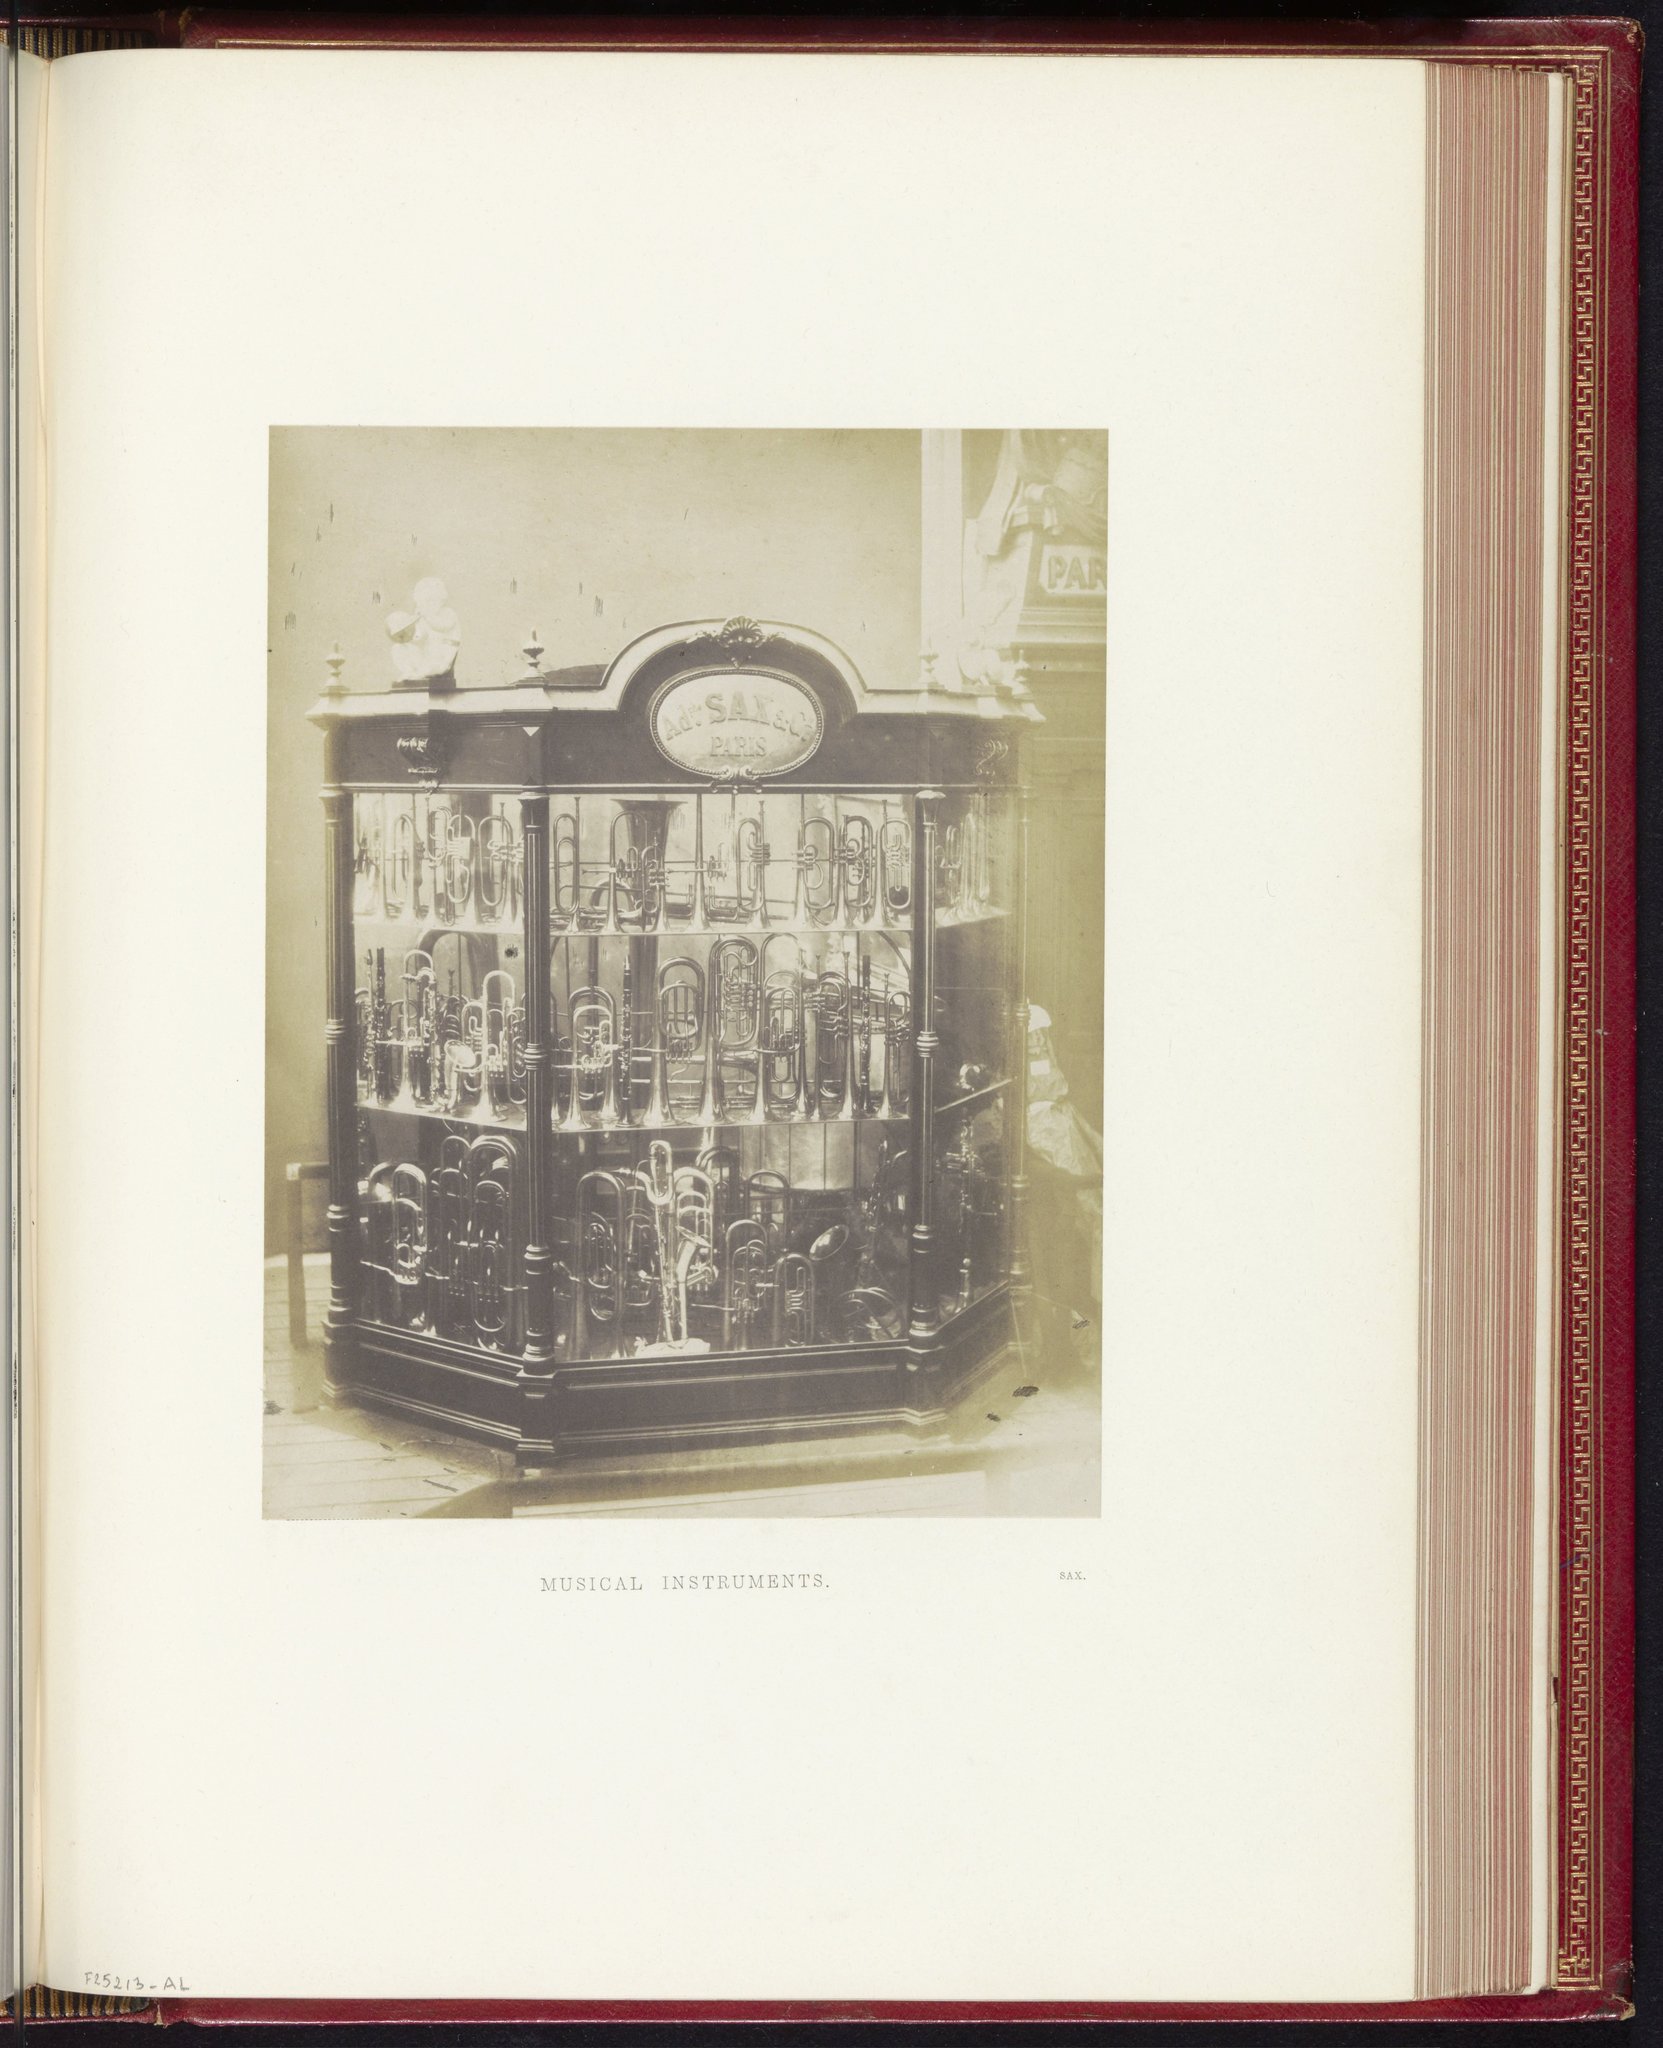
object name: page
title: Vitrine met blaasinstrumenten van Sax op de Great Exhibition of the Works of Industry of All Nations van 1851 in Londen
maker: Anonymous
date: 1851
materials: photographic support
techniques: salted paper print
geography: london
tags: wind instruments, london